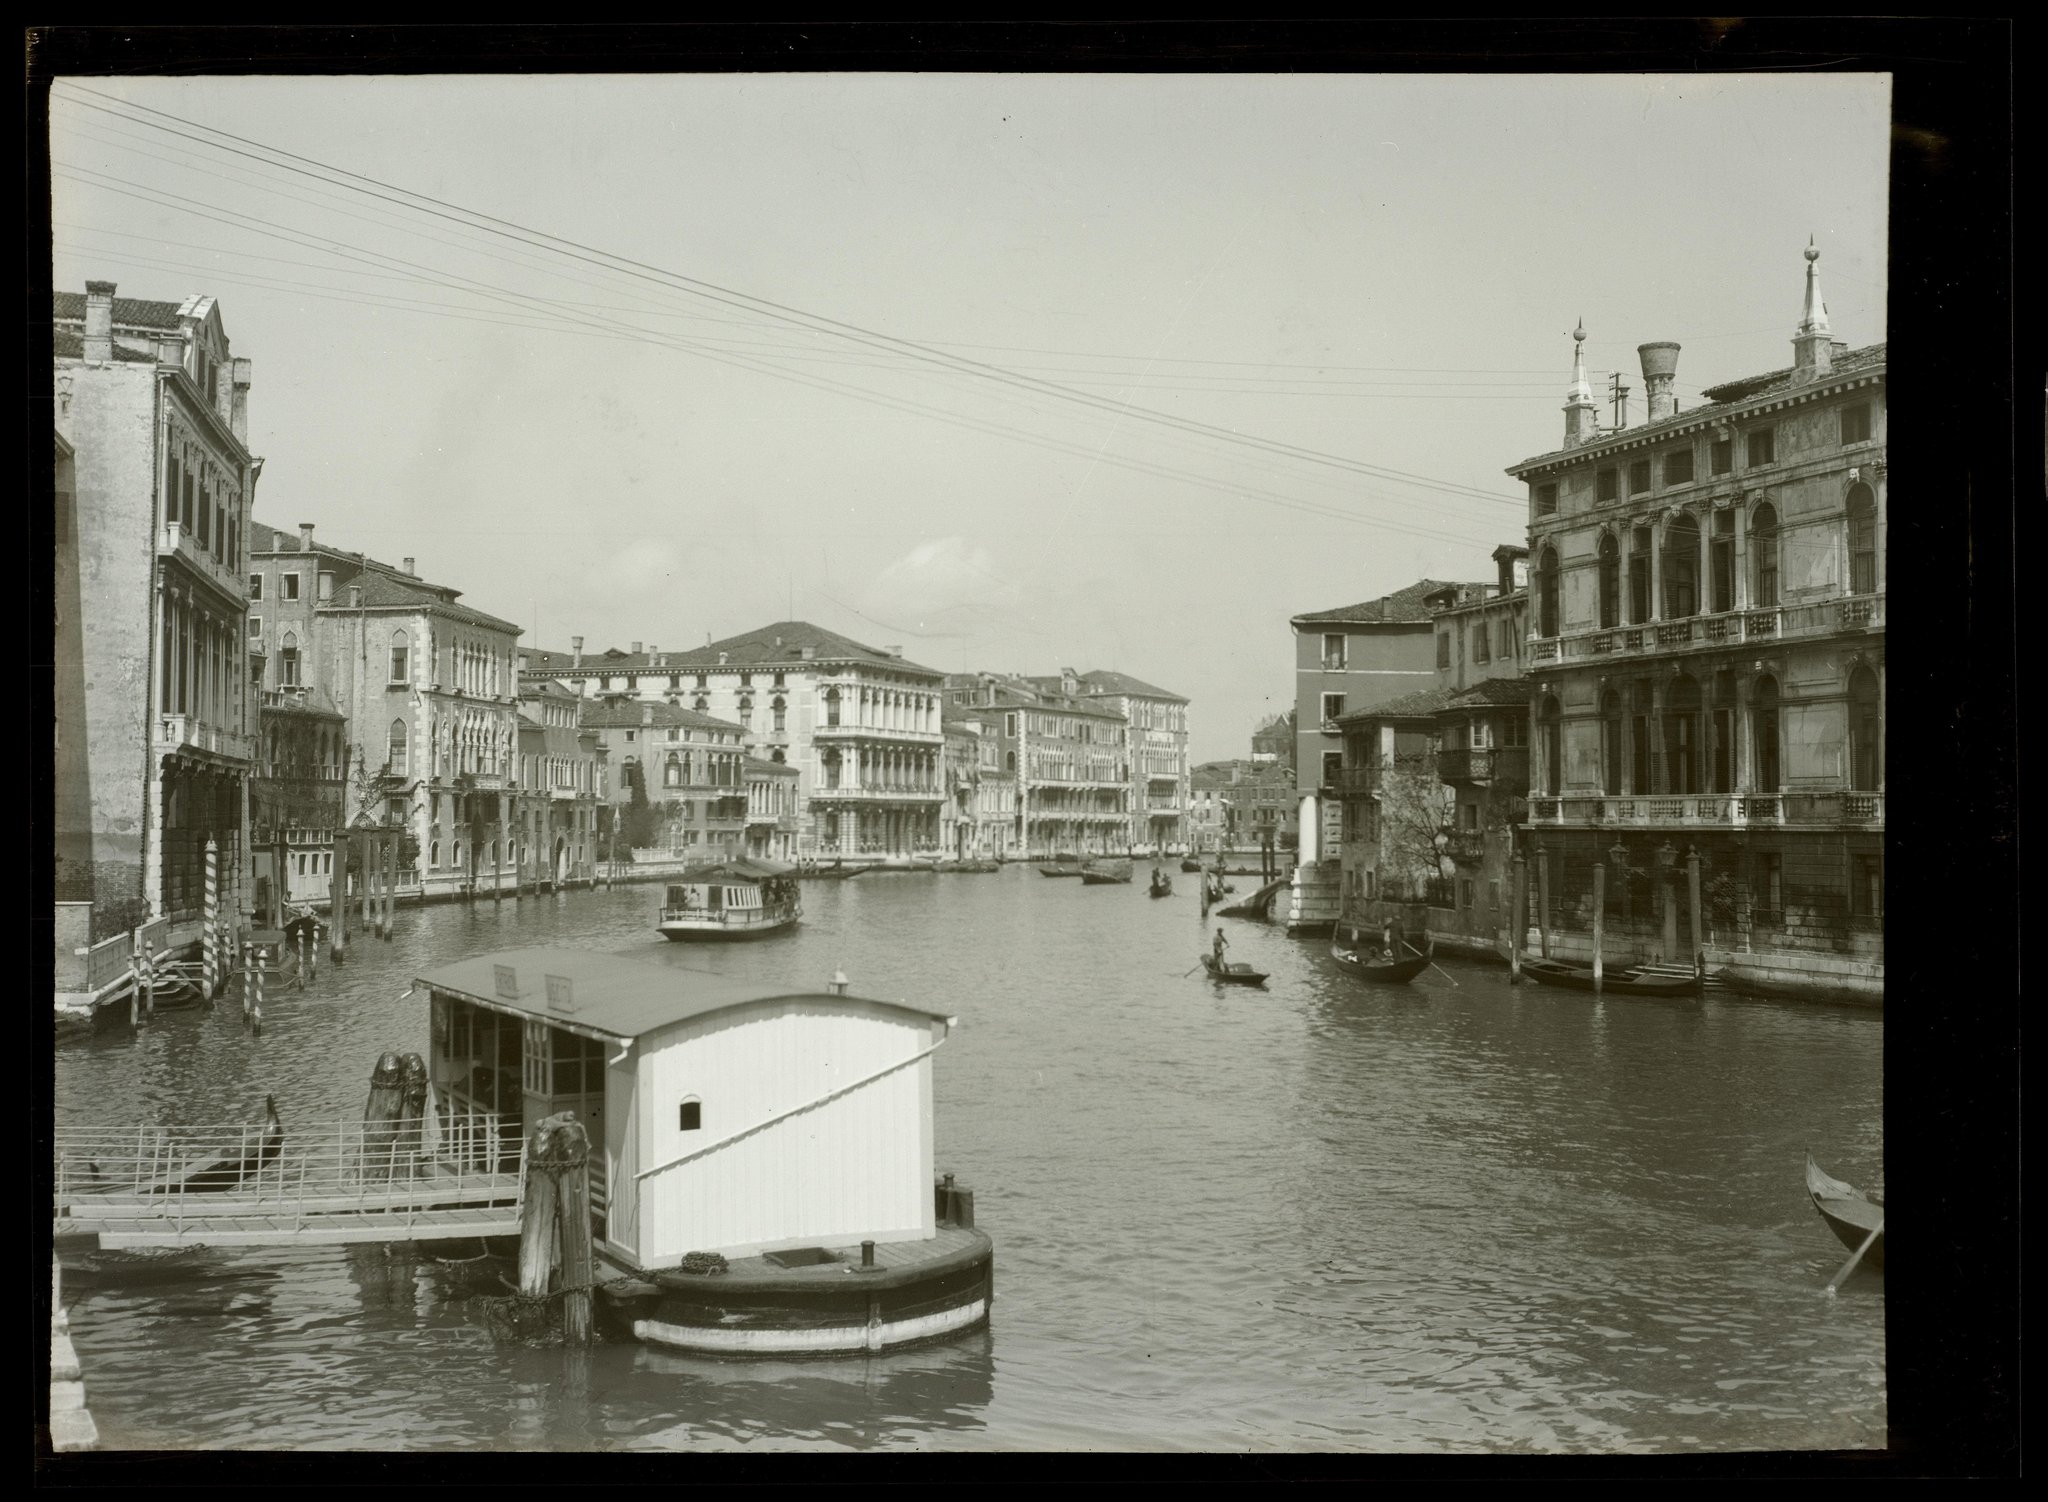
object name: photograph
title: Filmnegatief met opname van Venetië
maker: Anonymous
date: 1907-1935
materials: film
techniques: gelatin silver negative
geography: venice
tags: venice